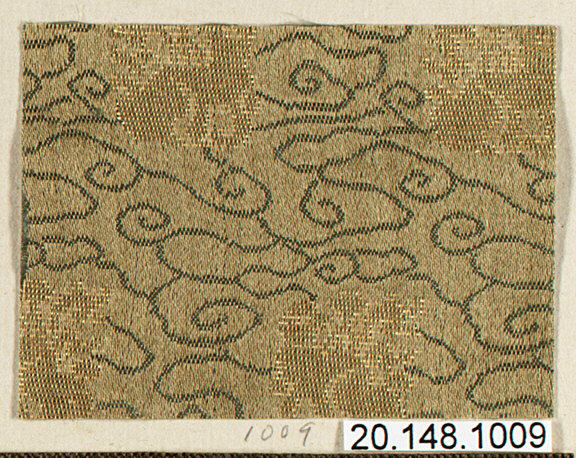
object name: piece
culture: japanese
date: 1801-1900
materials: silk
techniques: compound weave